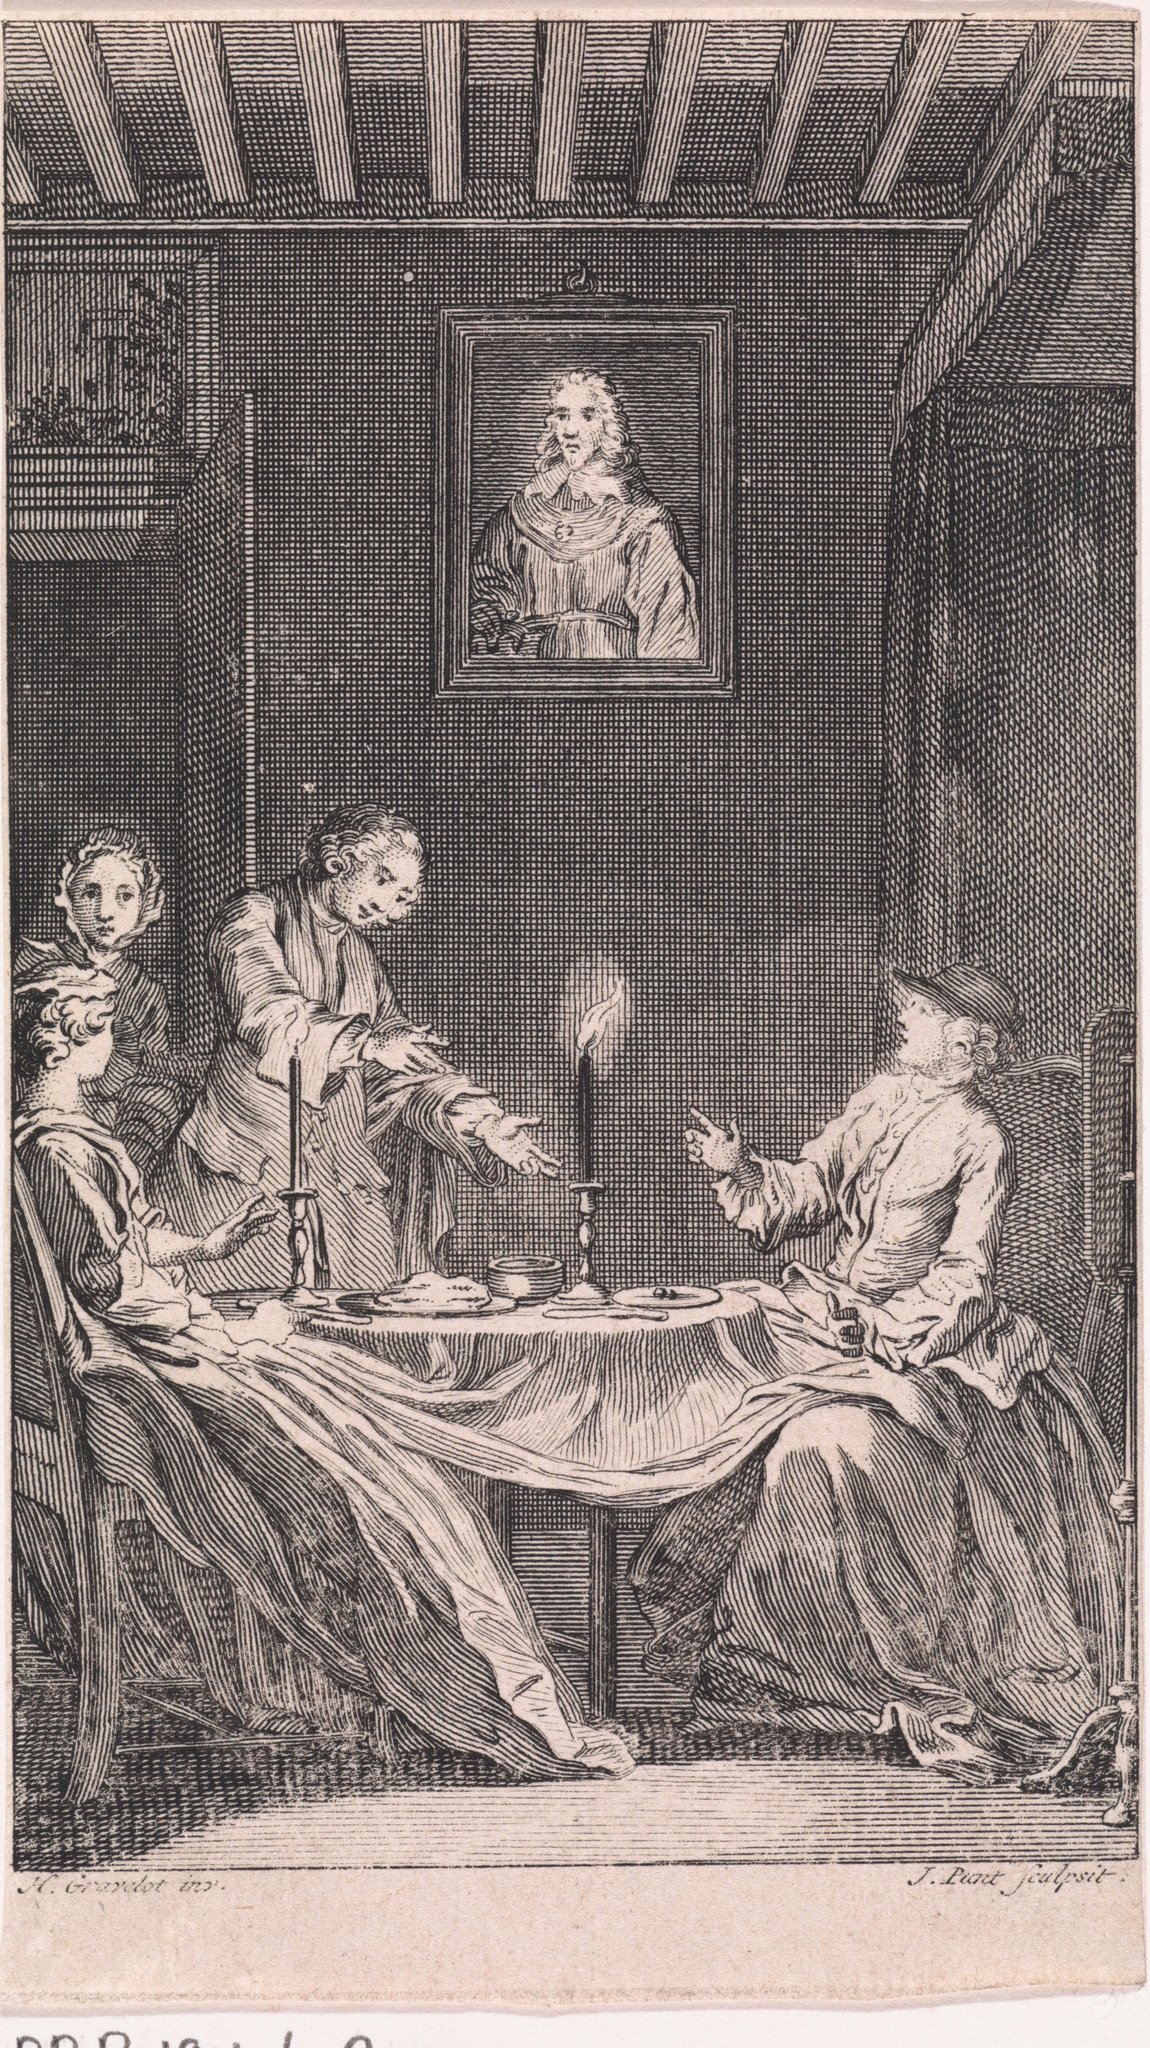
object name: book illustration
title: Sophia in gesprek met de waard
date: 1749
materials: paper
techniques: engraving, etching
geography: amsterdam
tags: hotel, hostelry, inn, specific works of literature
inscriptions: collector's mark: Lugt 2228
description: Prent gebruikt als illustratie in: Fielding, Henry. [Vertaald uit het Engels door] Pieter Le Clercq. Historie van den vondeling Tomas Jones, dl. 2, p. 510. Amsterdam: Gerrit de Groot, 1749.